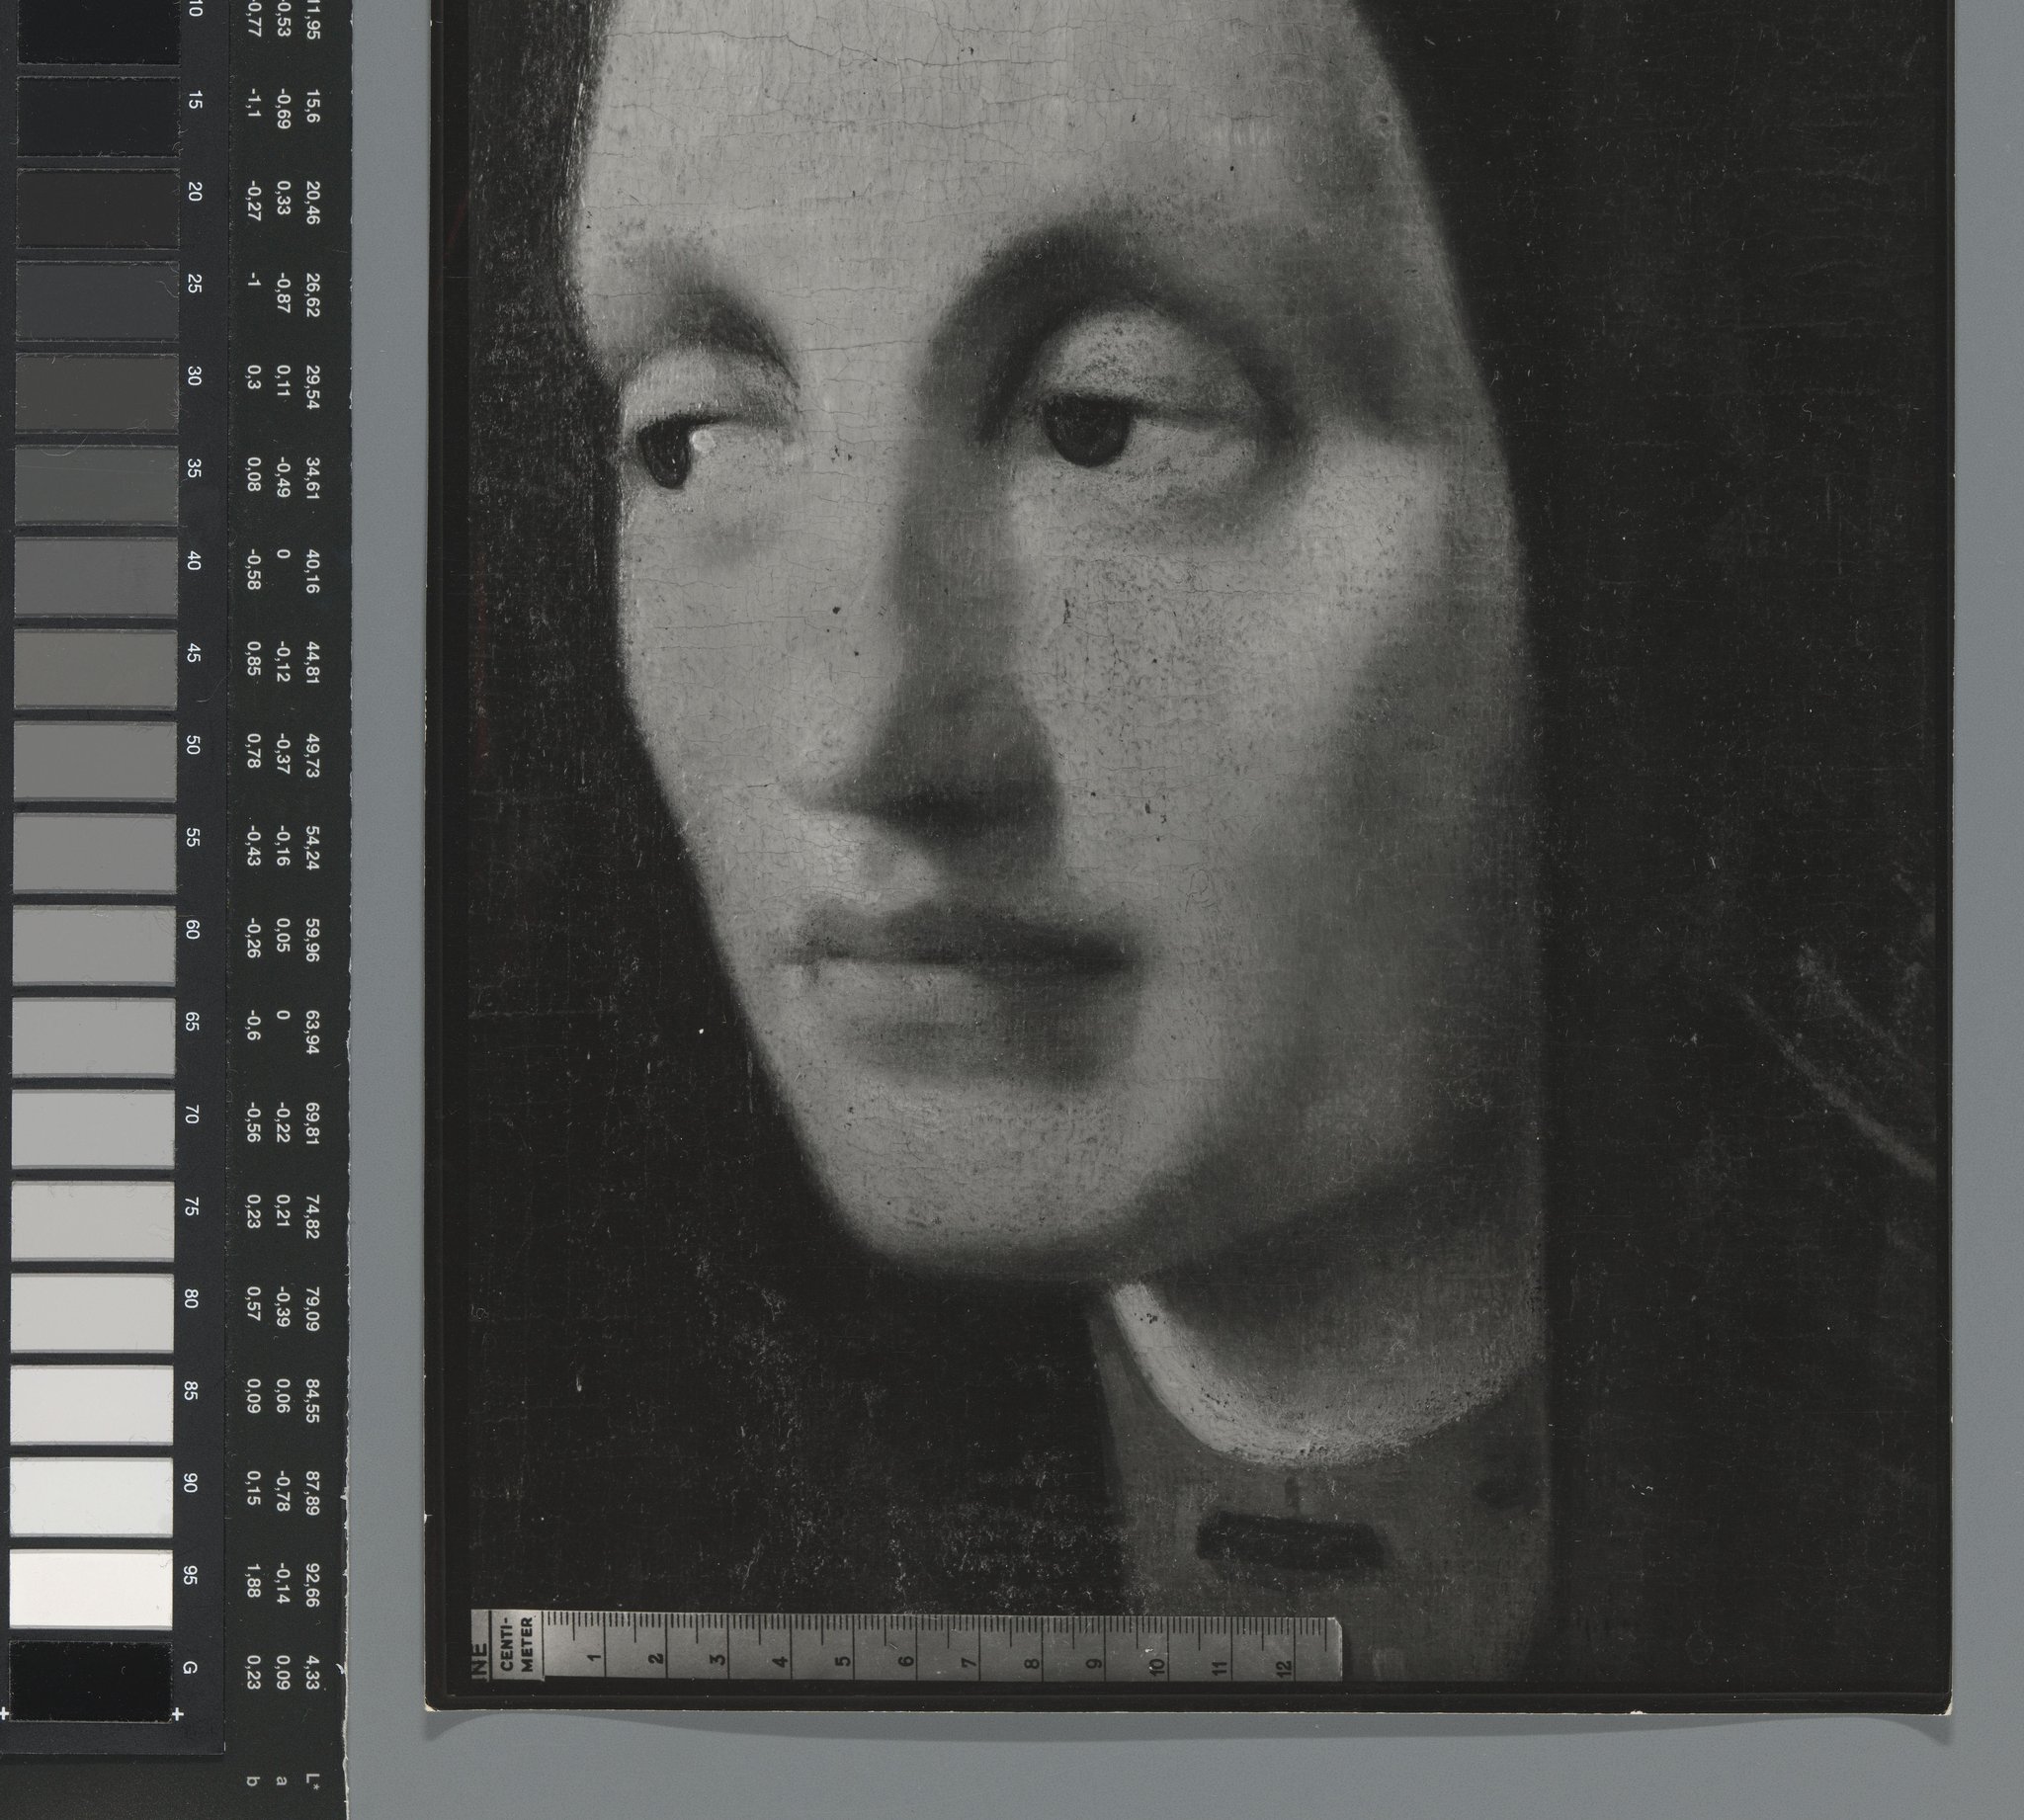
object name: photograph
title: Fotografische reproductie van een (detail) schilderij van Han van Meegeren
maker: nico zomer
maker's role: fotograaf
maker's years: 1910-1988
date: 1908-1948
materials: photographic support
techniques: gelatin silver print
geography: amsterdam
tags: picture, painting